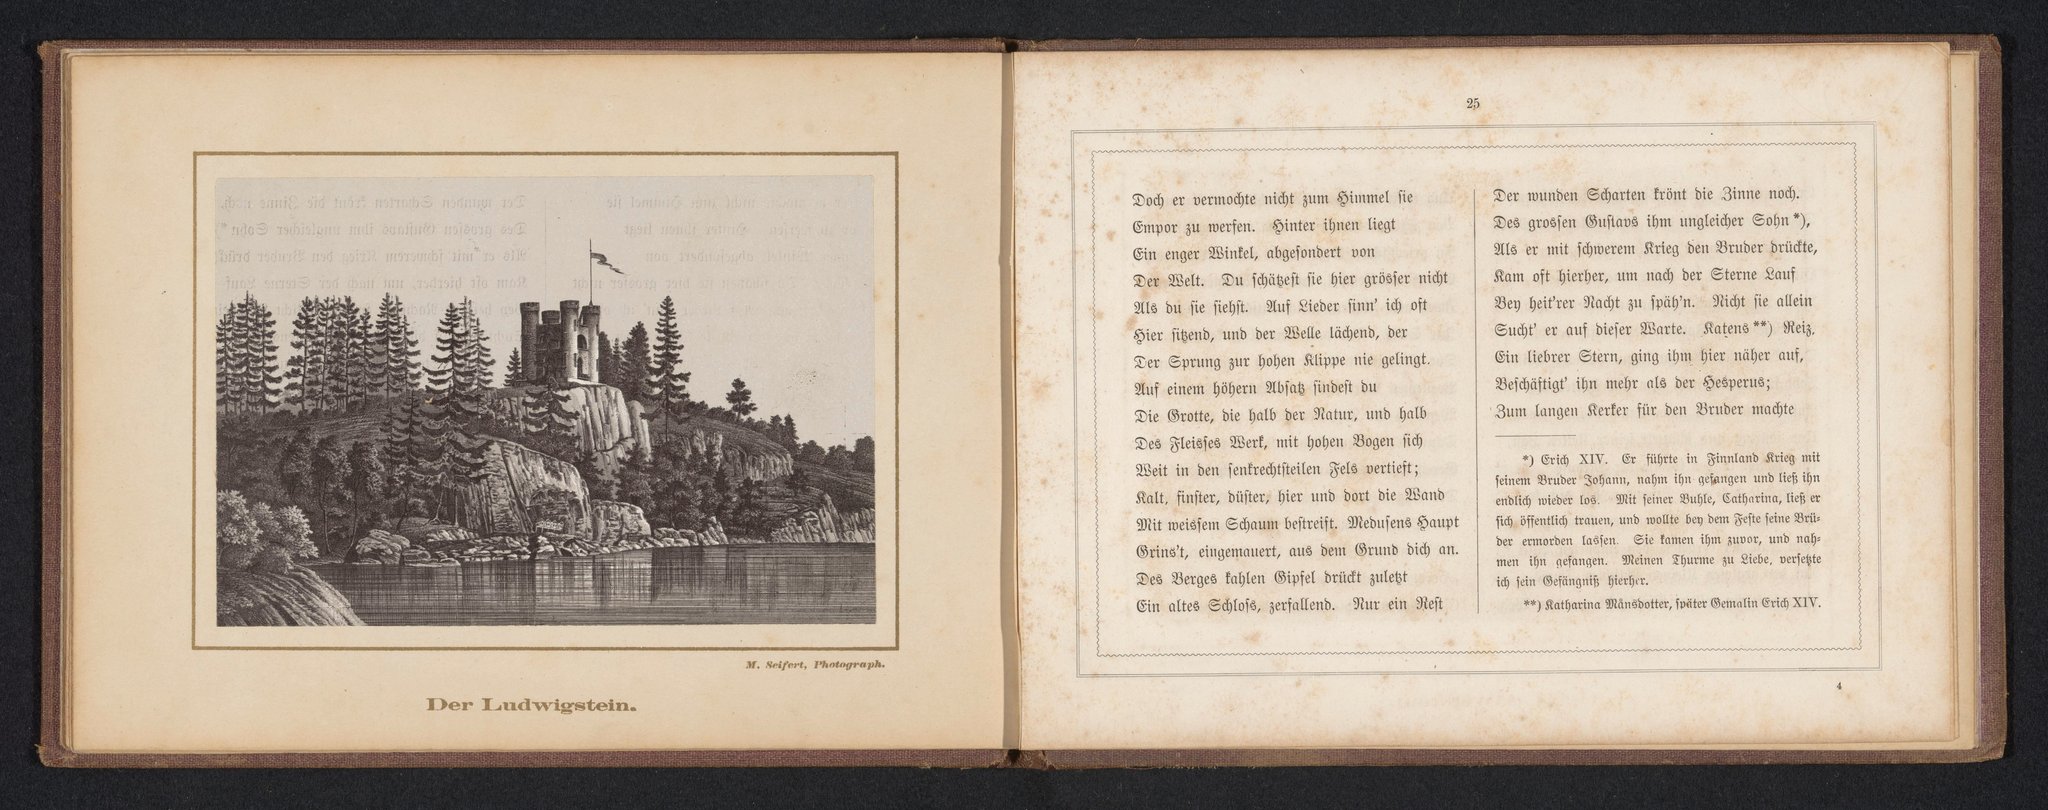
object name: page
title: Der Ludwigstein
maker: m. seifert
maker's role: fotograaf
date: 1865-1875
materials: paper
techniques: photolithography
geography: frankfurt am main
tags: island, garden